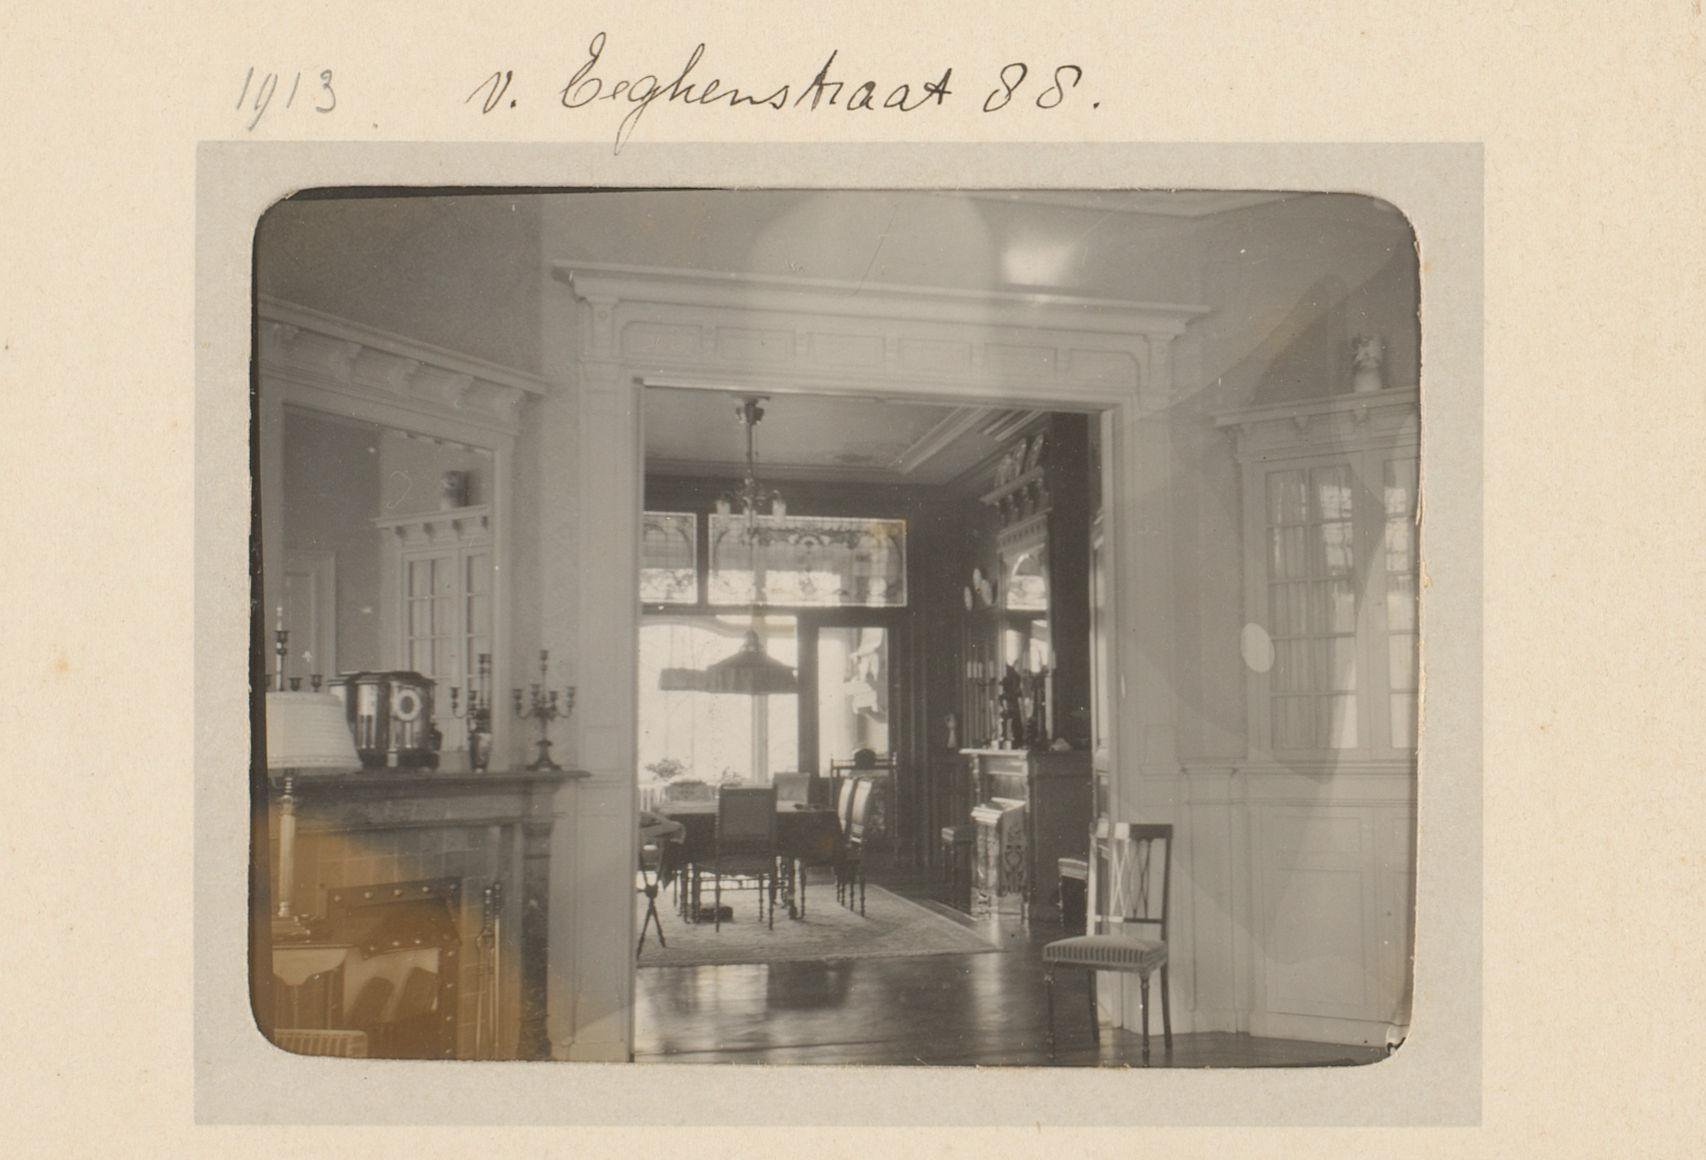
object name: album leaf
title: Interieur van de Van Eeghenstraat 88 te Amsterdam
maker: liesbeth overhoff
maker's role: fotograaf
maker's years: 1895-1969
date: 1913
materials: paper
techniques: gelatin silver print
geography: amsterdam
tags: open hearth, fire-place, interior ~ representation of a building, dining-room, amsterdam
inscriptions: inscription: ‘1913. v. Eeghenstraat 88.’